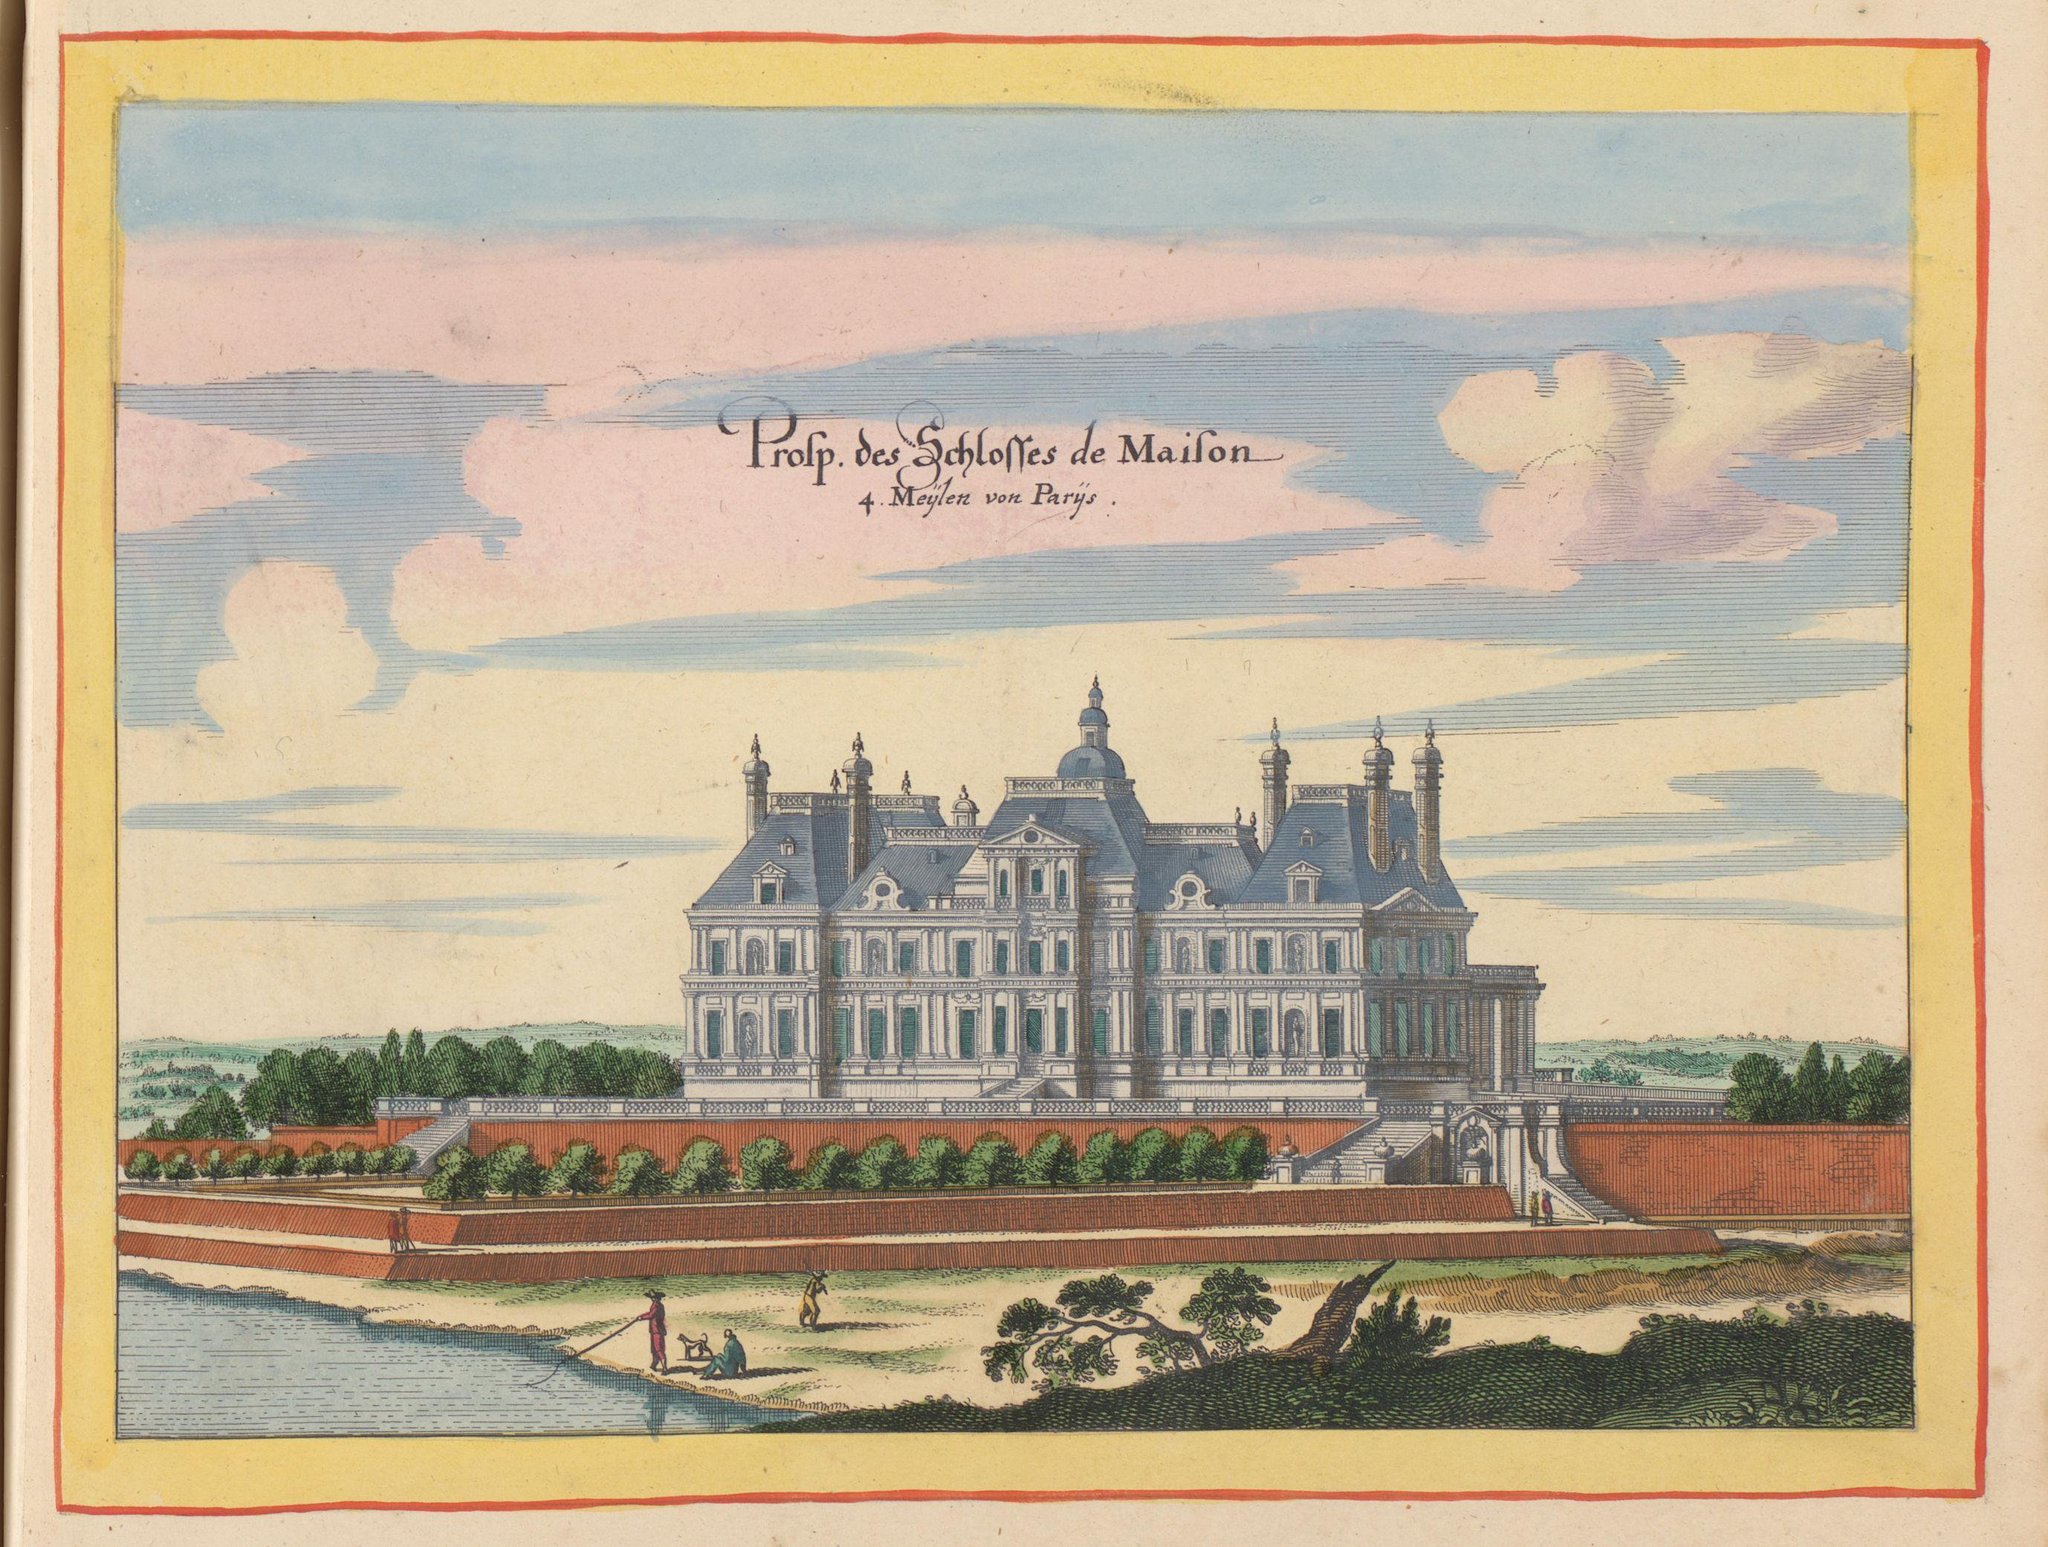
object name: print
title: Gezicht op Château de Maisons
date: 1655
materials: paper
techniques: engraving, etching, hand coloring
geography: frankfurt am main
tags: castle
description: Prent origineel vervaardigd als boekillustratie voor: Zeiller, Martin. Topographia Galliae, oder Beschreibung und Contrafaitung der vornehmbsten und bekantisten Oerter in dem mächtigen und grossen Königreich Frankreich, 13 delen. Frankfurt am Main: Caspar Merian, 1655-1661. De prent werd voor het eerst gepubliceerd in deel 1: Topographia Galliae, 1655. De prent is langs de bovenrand van de voorstelling afgescheurd. De voorstelling is aan de bovenzijde aangevuld met een geschilderde lucht.